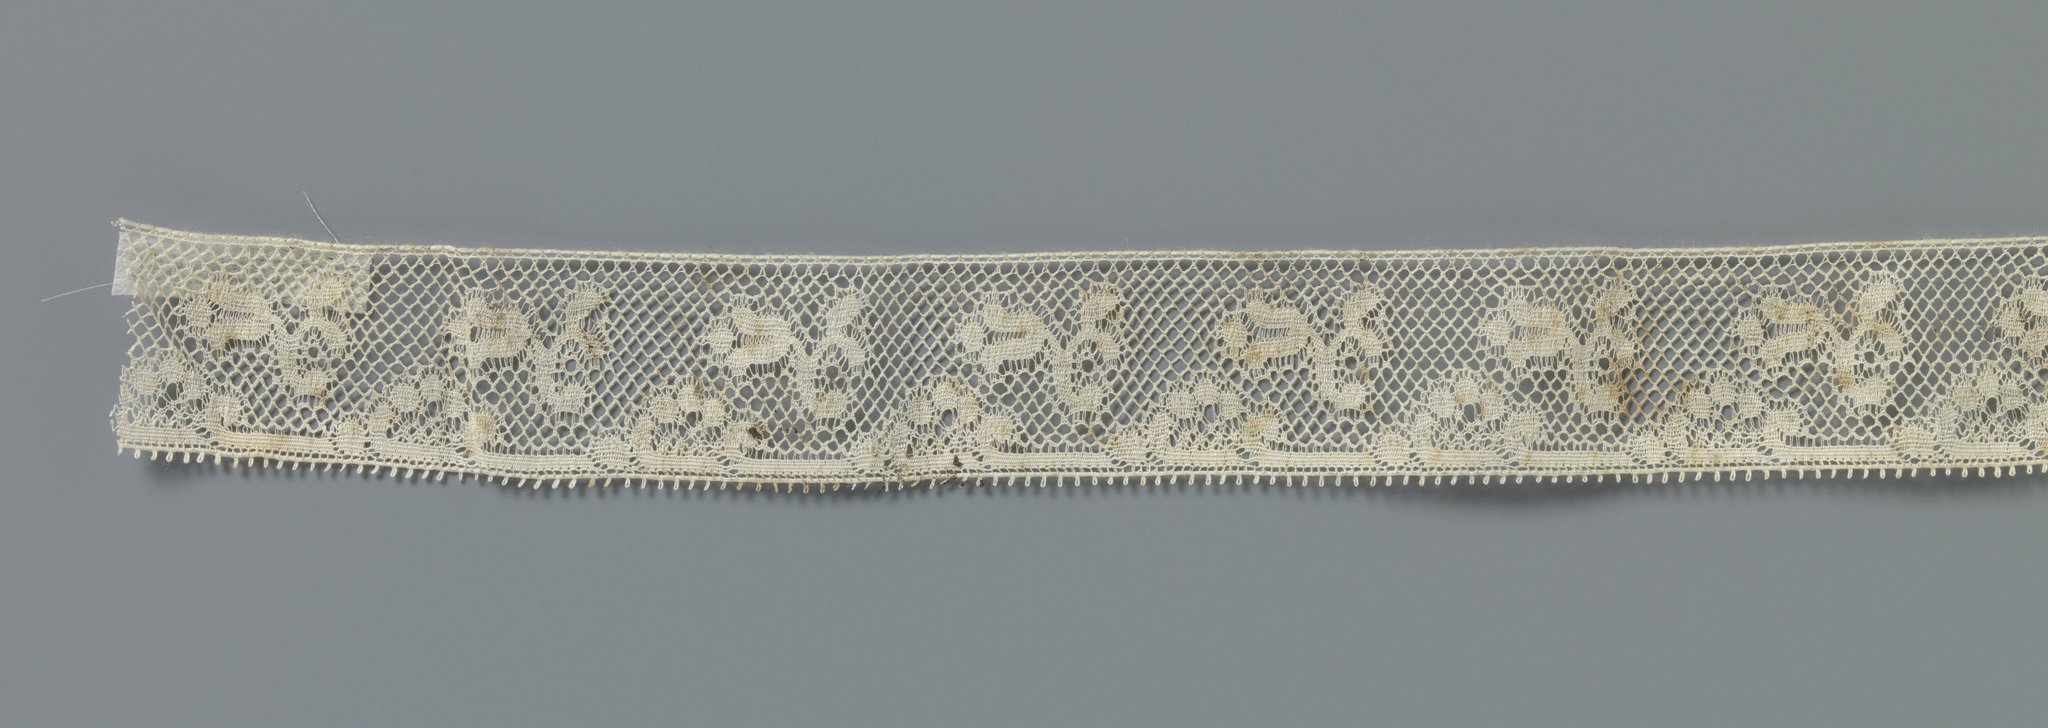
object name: strip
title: Strook machinale kant met kelkbloempje aan c-vormig takje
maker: Anonymous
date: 1850-1899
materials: cotton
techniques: lace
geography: france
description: Strook naturelkleurige machinale kant: machinale Valenciennes-kant. Het zich herhalende patroon bestaat uit een c-vormig takje waaruit de bolle kant van de c een kelkbloempje ontspringt en aan de top van de c een blaadje. Langs de onderzijde van de strook ligt een aaneenschakeling van een kortere en langere rechte lijnen, die aan de uiteinden iets omhoog krullen. Tussen de omkrullende uiteinden is tussen de bloemen in met cirkeltjes een soort halfcirkelvormig cartouche gerealiseerd, waarin een siergrond is toegepast. De motieven lijken te zijn gemaakt in linnenslag met opengewerkte randjes. De motieven zijn met elkaar verbonden door een machinale vierkante Valenciennes-grond. Boven- en onderzijde van de strook zijn recht afgewerkt waarbij de onderzijde is voorzien van picots.